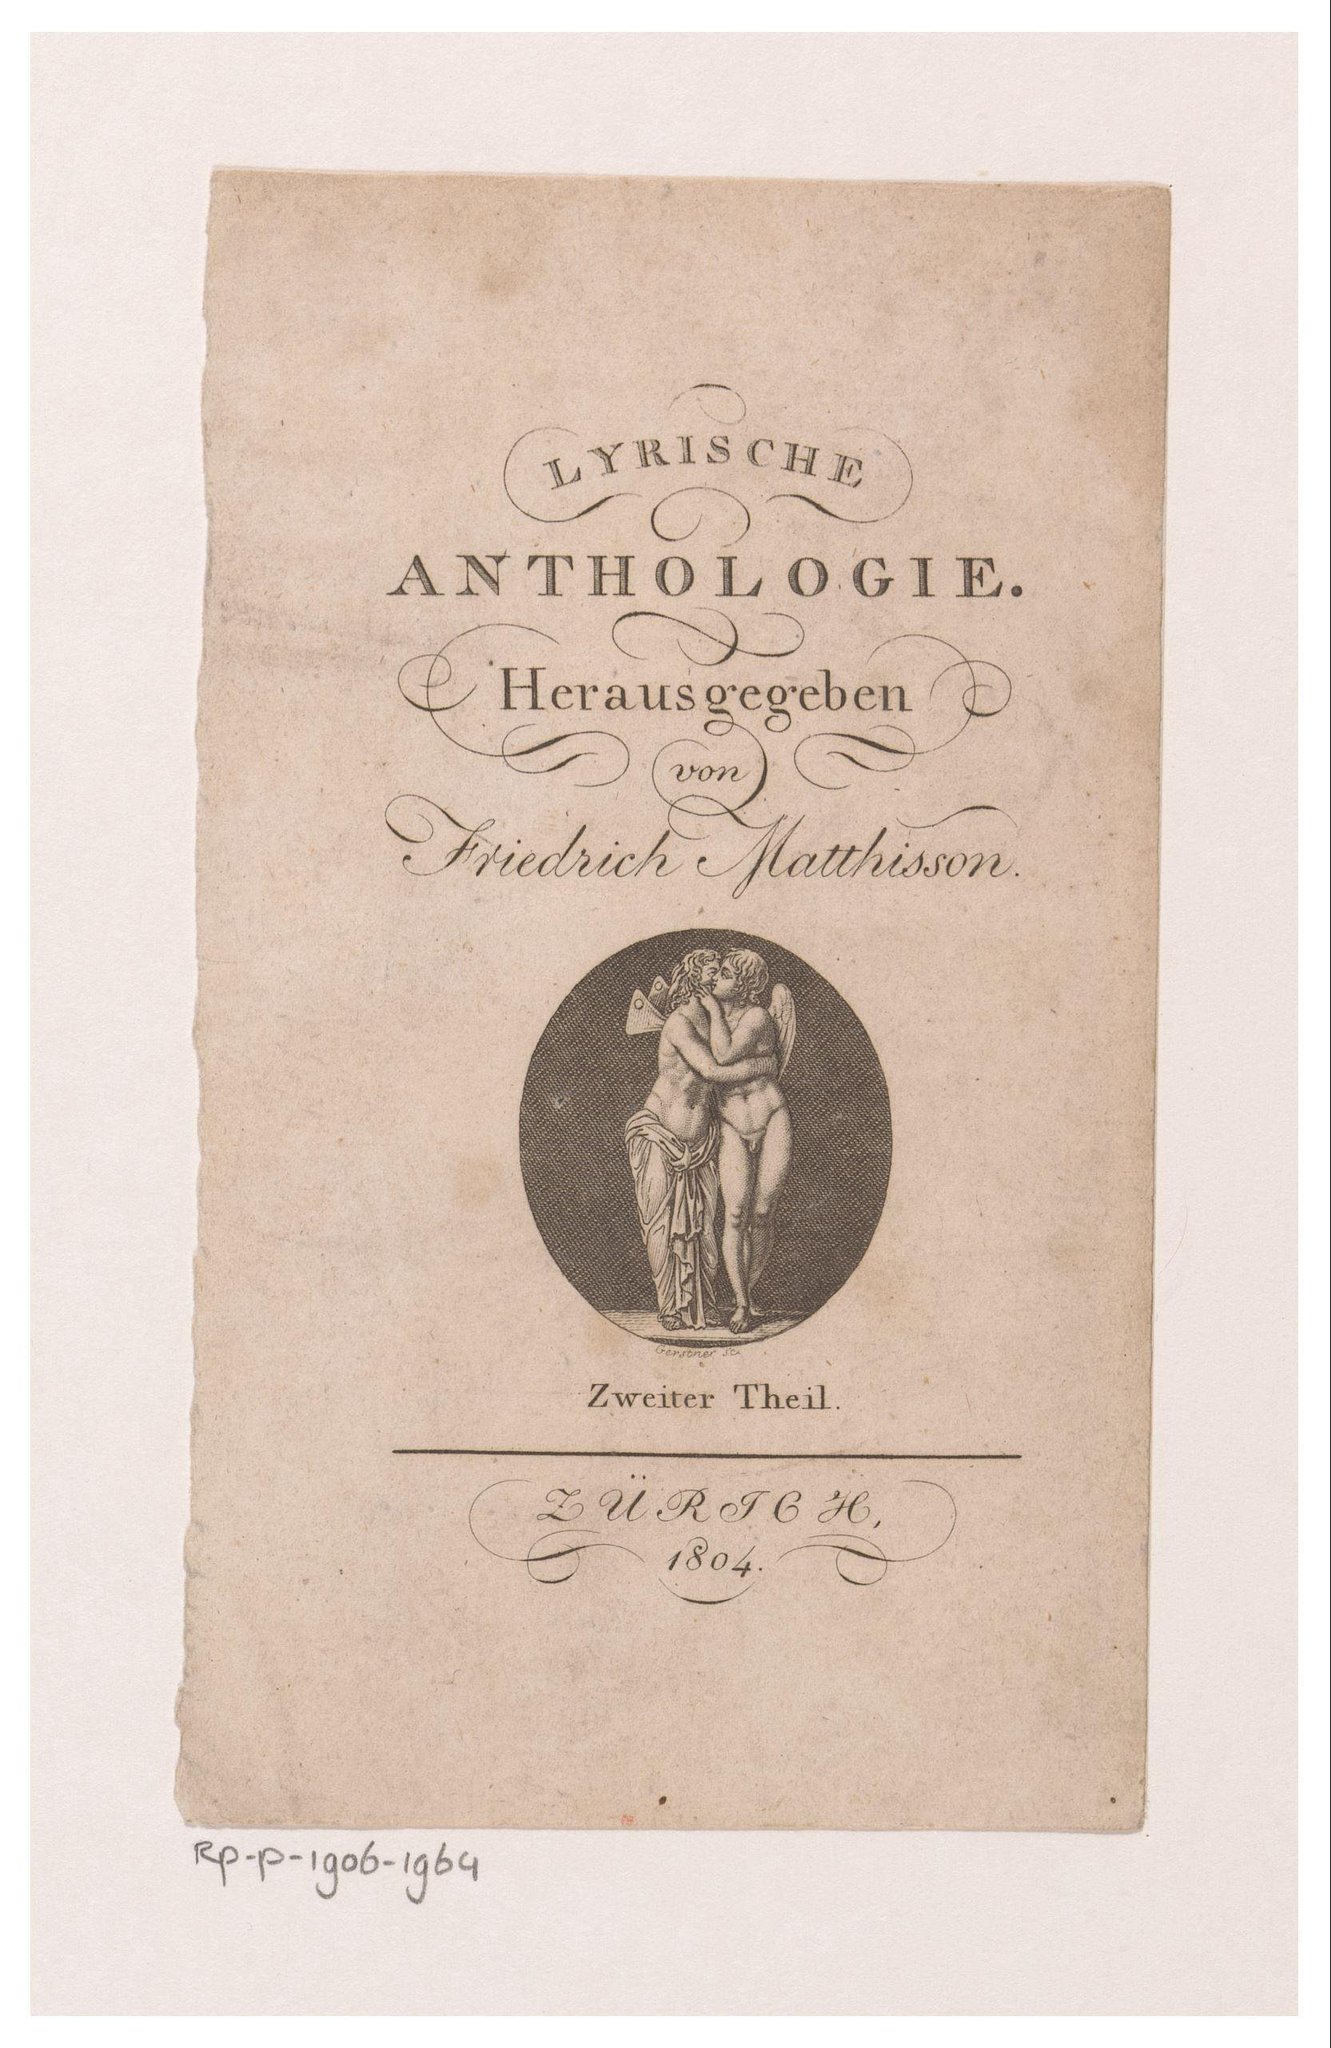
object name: print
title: Twee gevleugelde figuren kussen elkaar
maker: joseph gerstner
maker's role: print maker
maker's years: 1768-1813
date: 1804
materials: paper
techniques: engraving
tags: (lovers) kissing each other, fabulous beings with wings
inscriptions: collector's mark: Lugt 2228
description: Prent uit: Matthisson, Friedrich. Lyrische Anthologie. Zürich: s.n., 1804, dl. 2.